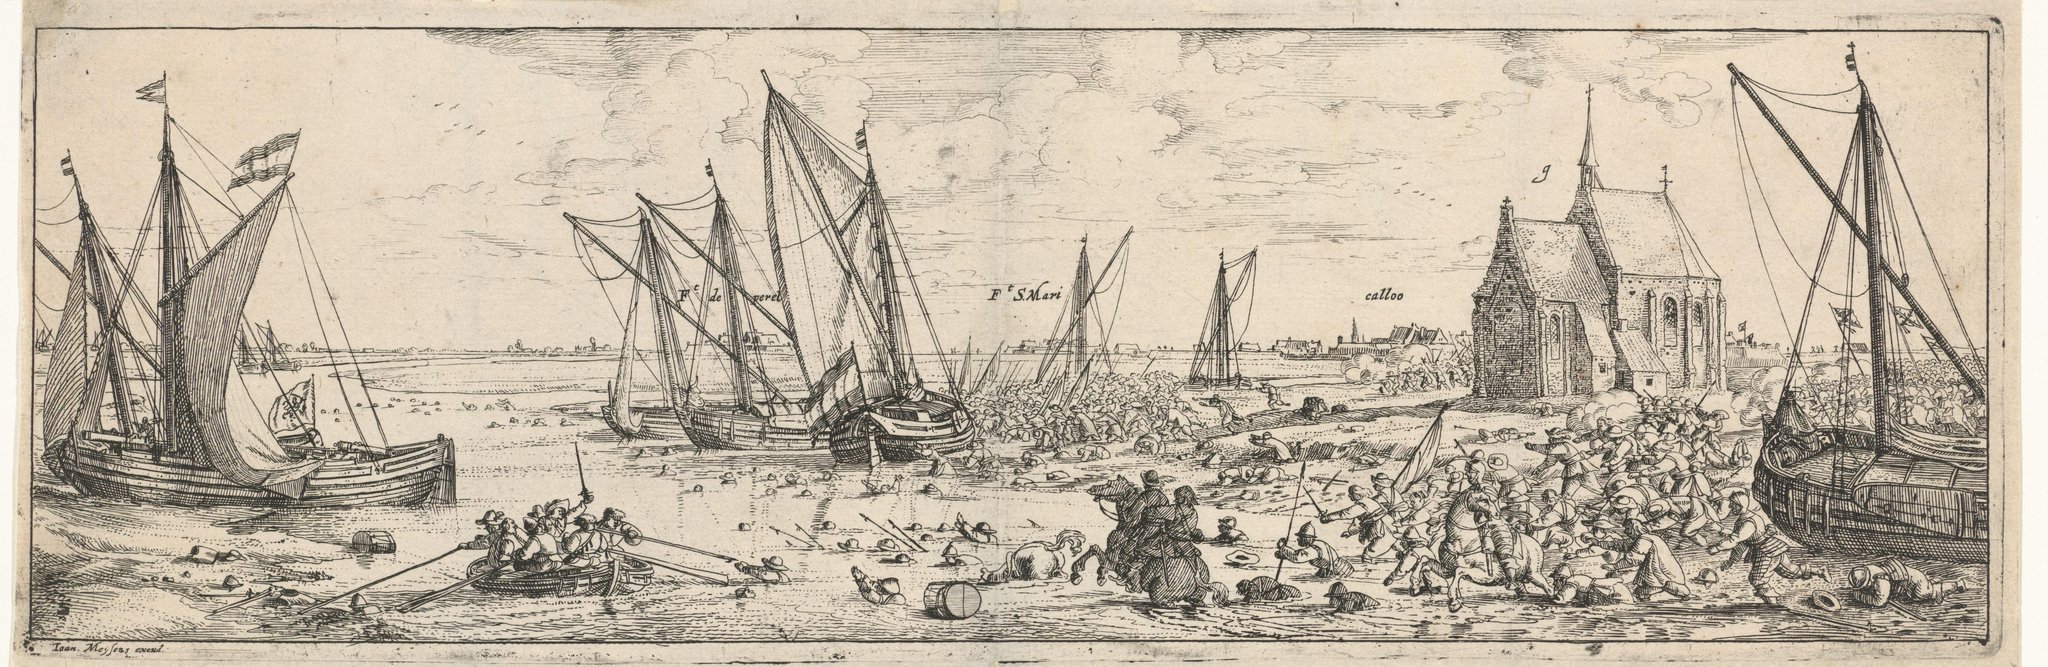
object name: print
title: Mislukte aanval op fort Kallo, 1638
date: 1638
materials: paper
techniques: etching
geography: antwerp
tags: (military) attack, putting the enemy to flight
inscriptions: collector's mark: Lugt 2228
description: Vluchtende soldaten van het Staatse leger onder graaf Willem van Nassau-Siegen na de mislukte aanval op de schans bij Kallo, 21 juni 1638. De soldaten proberen door het water de gereedstaande boten te bereiken. Rechts het kerkje van Kallo. Deel van een ensemble van twee platen en twee tekstbladen in het Nederlands en Frans.